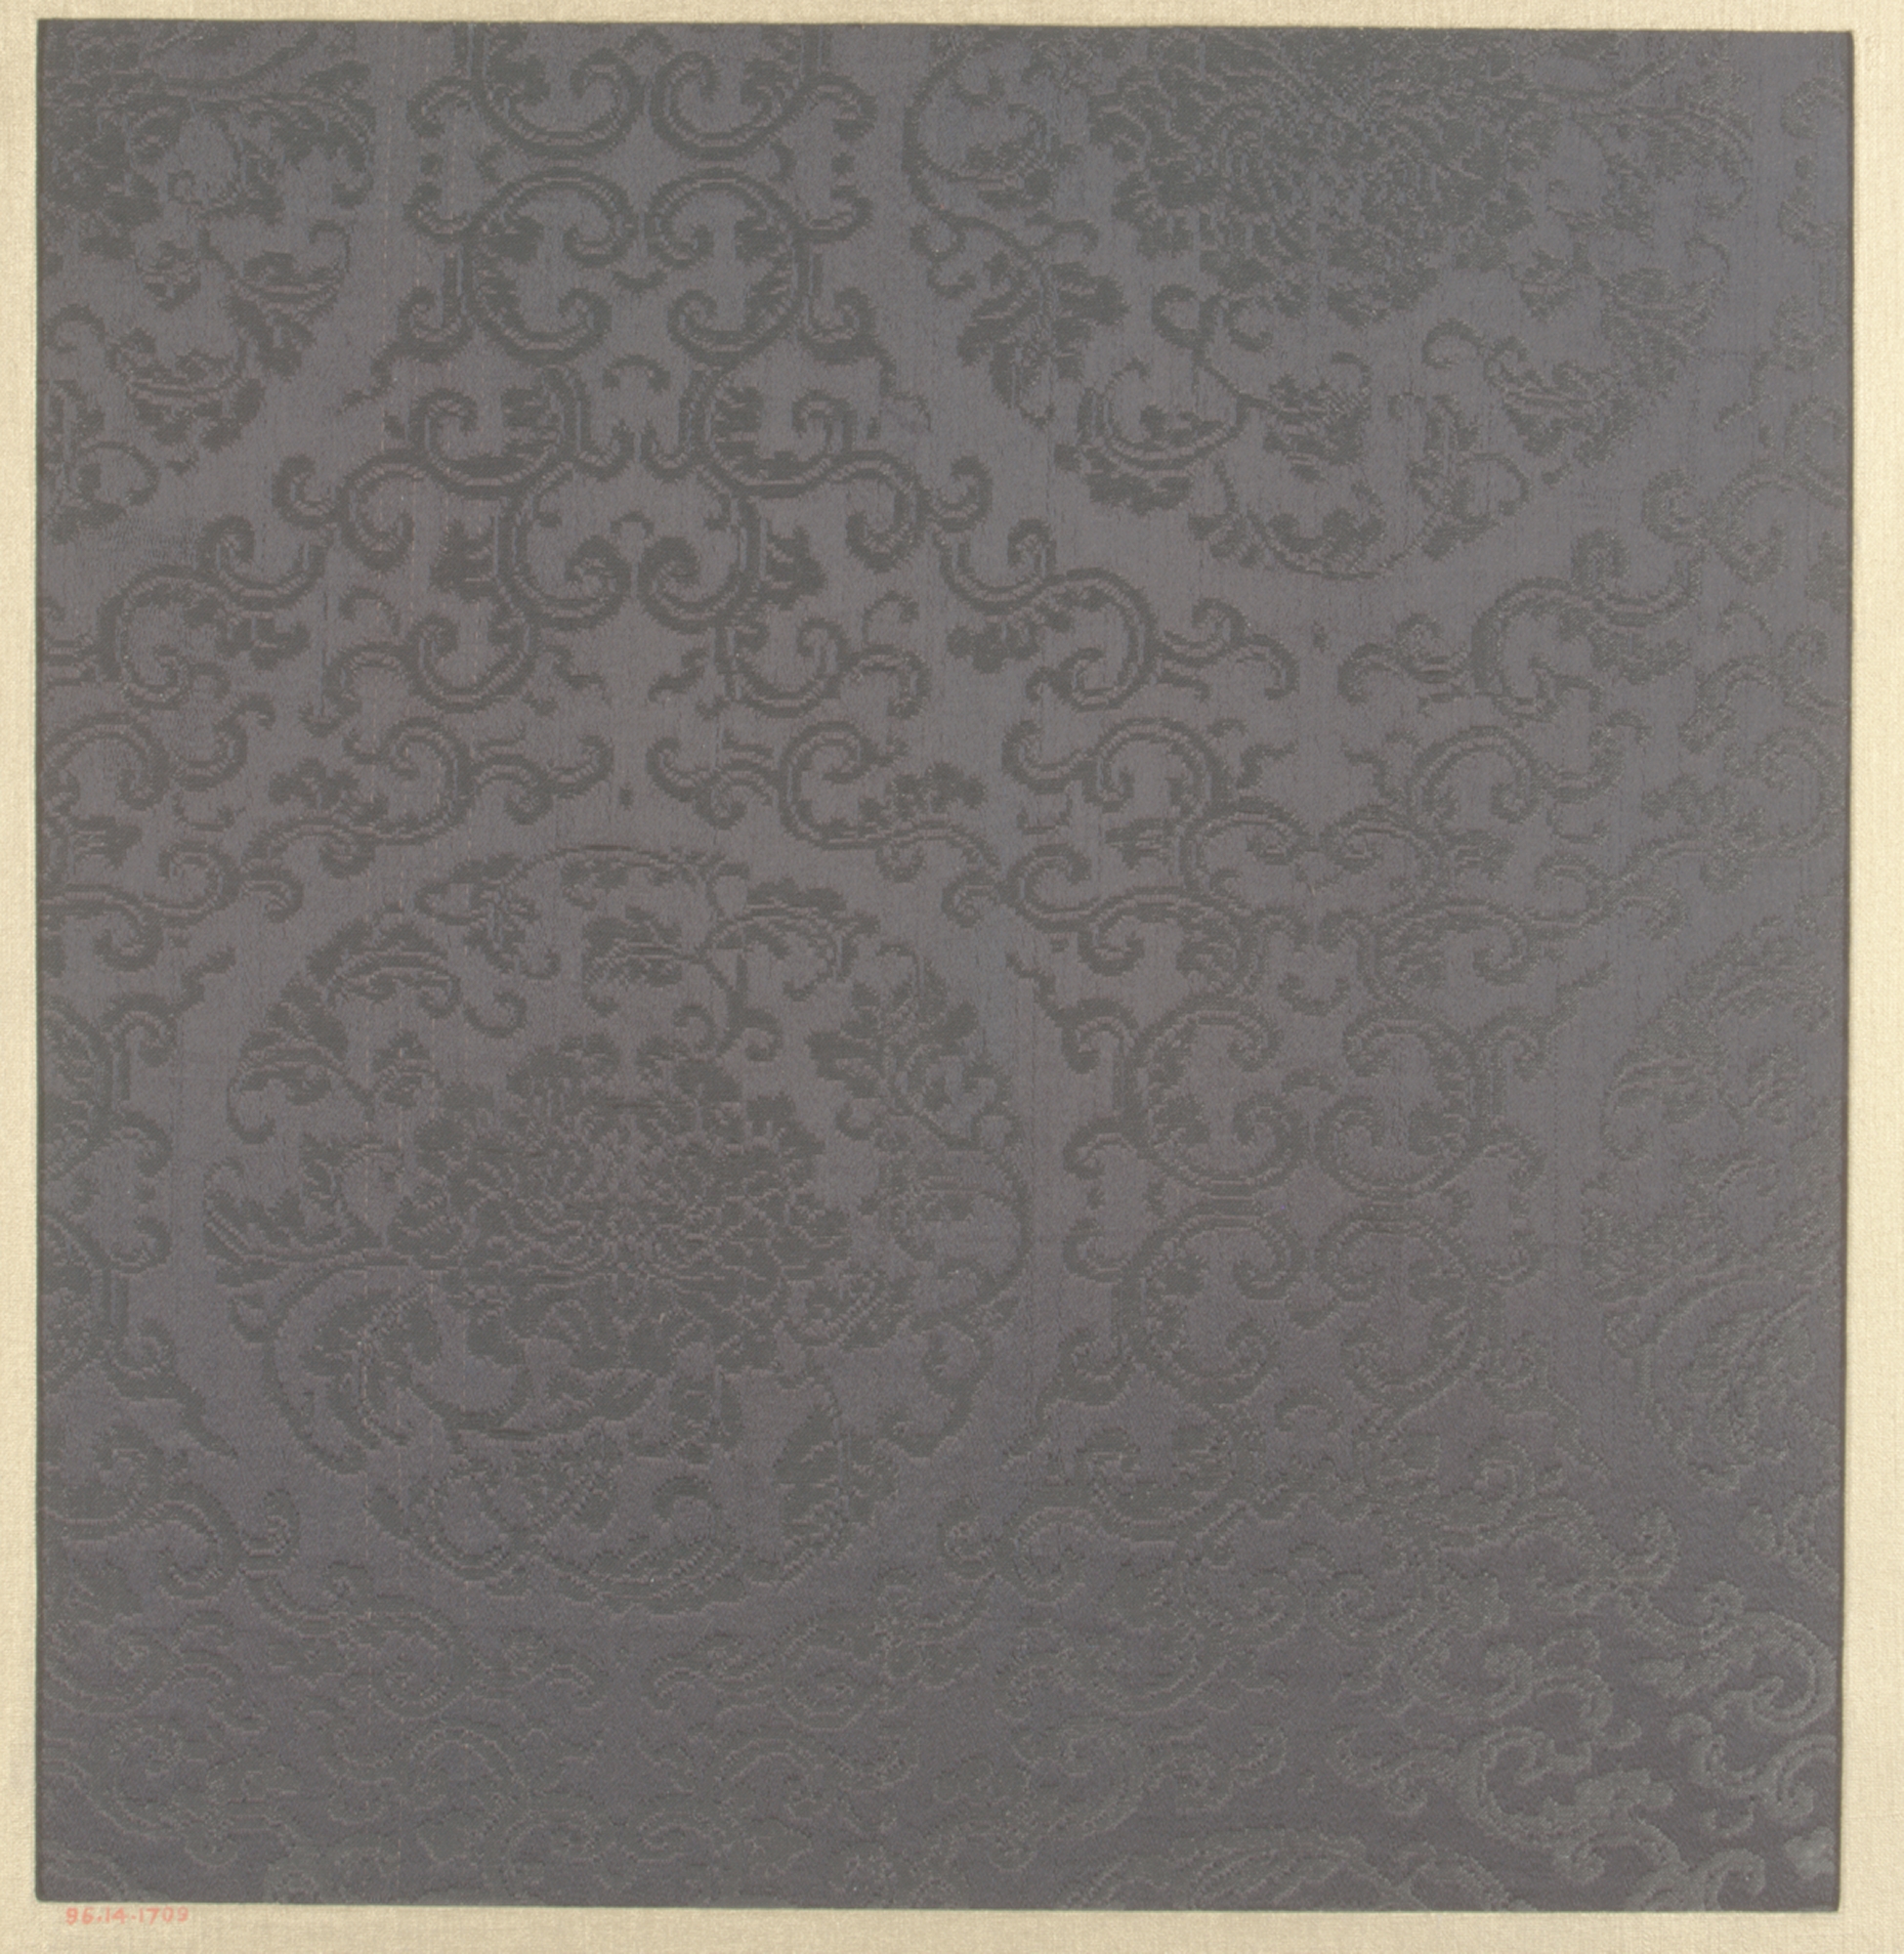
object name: piece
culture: japanese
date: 1701-1900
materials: silk